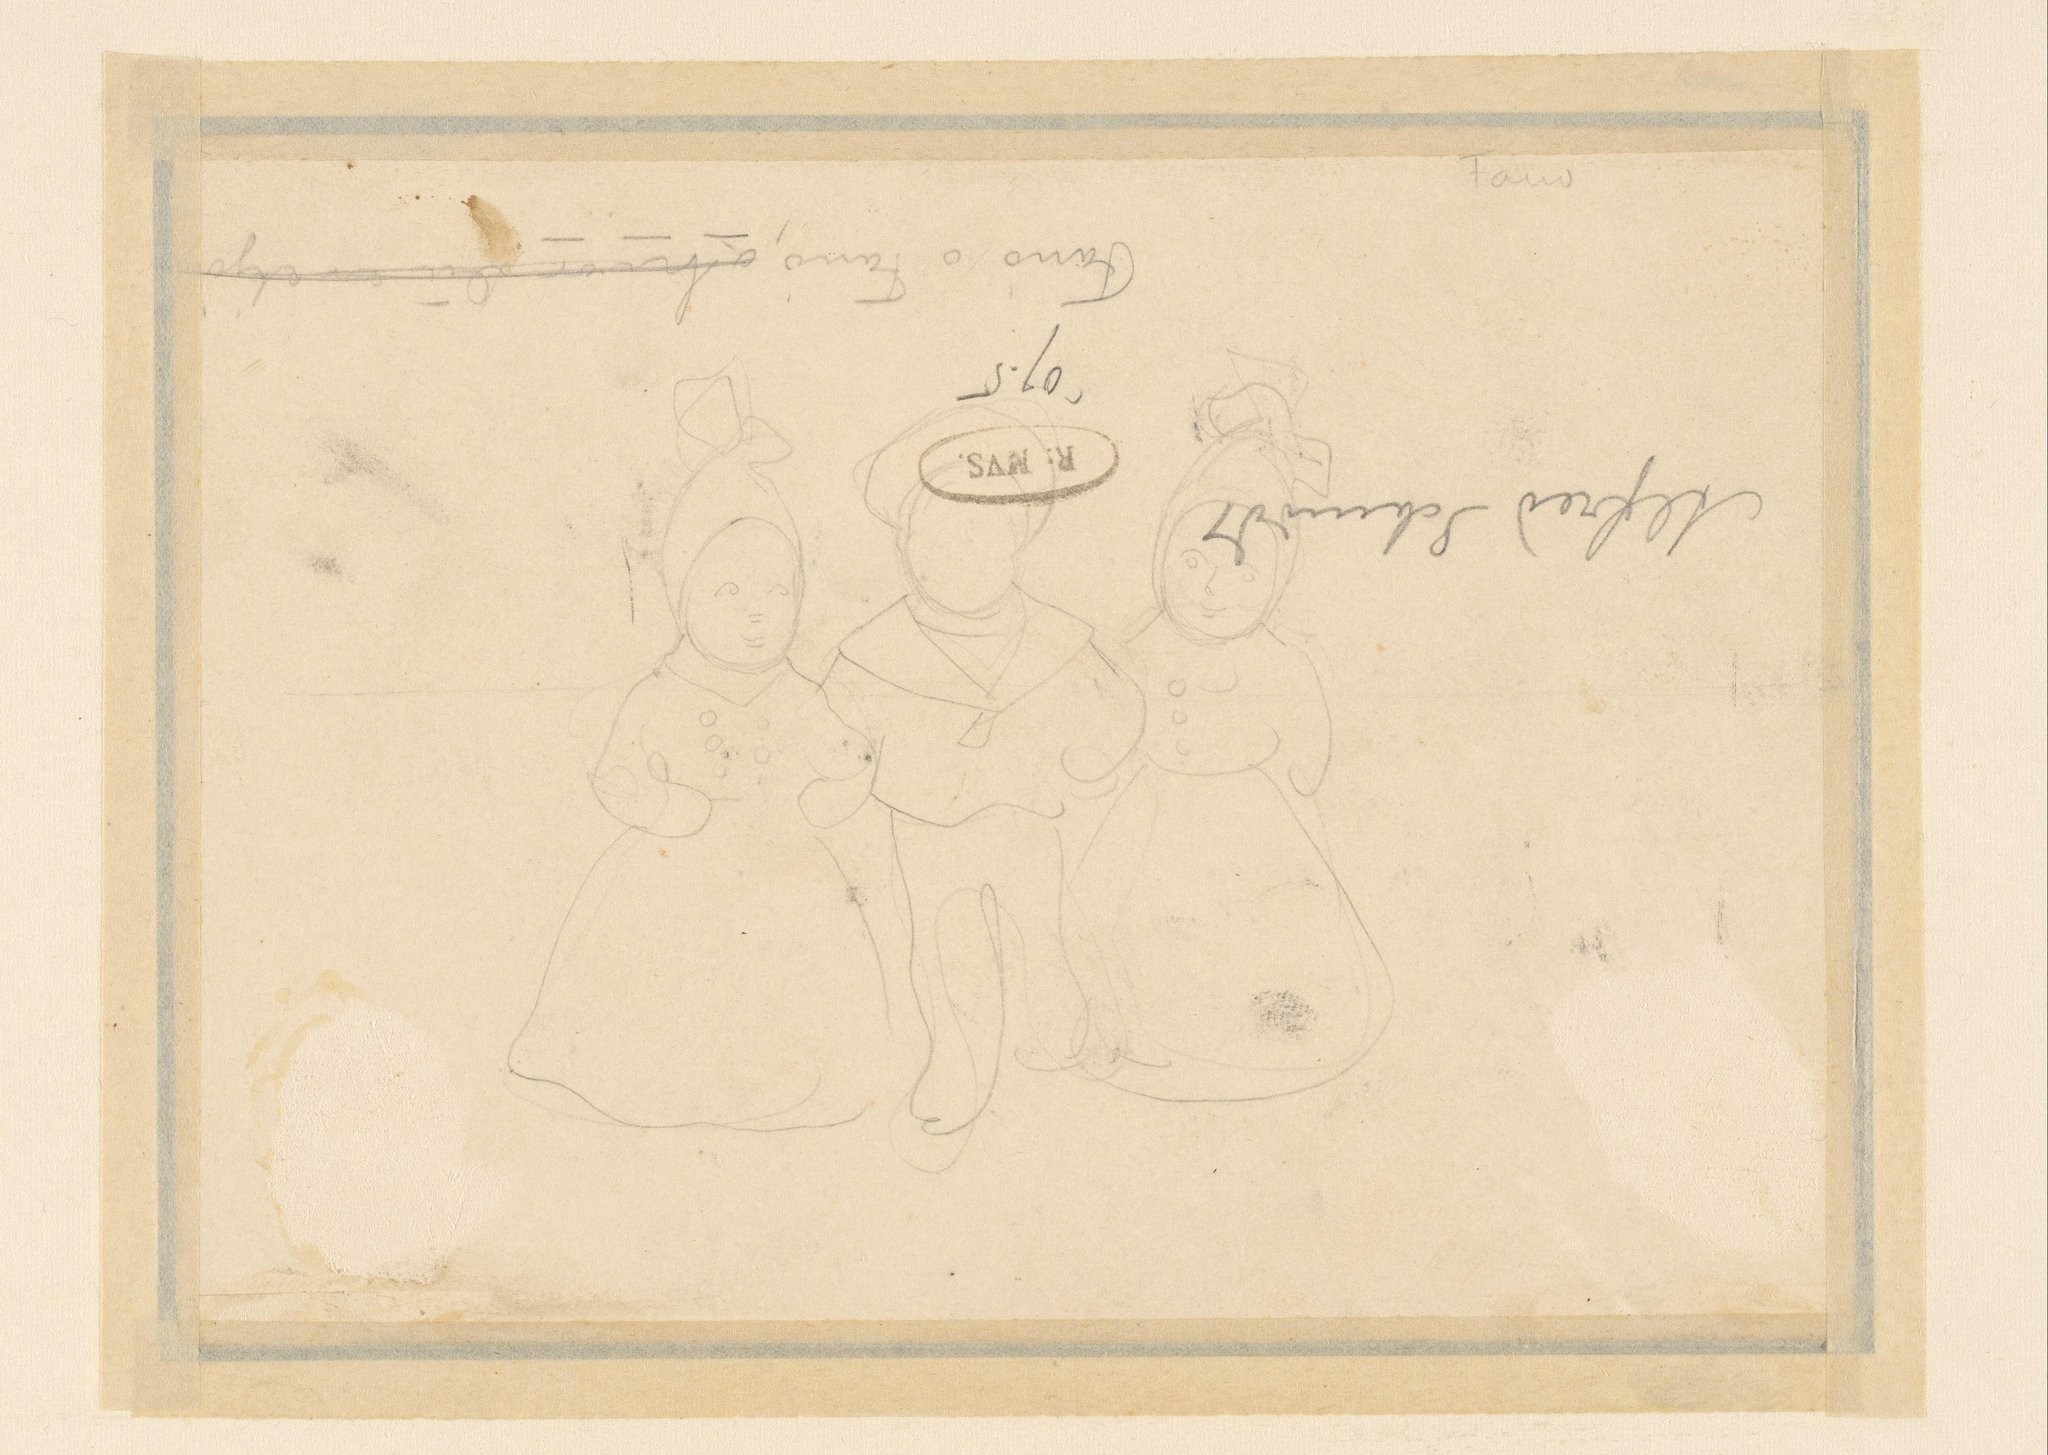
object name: drawing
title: Man gearmd wandelend tussen twee dames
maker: alfred michael roedstad schmidt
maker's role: draughtsman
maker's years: 1858-1938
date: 1868-1907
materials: paper, pencil